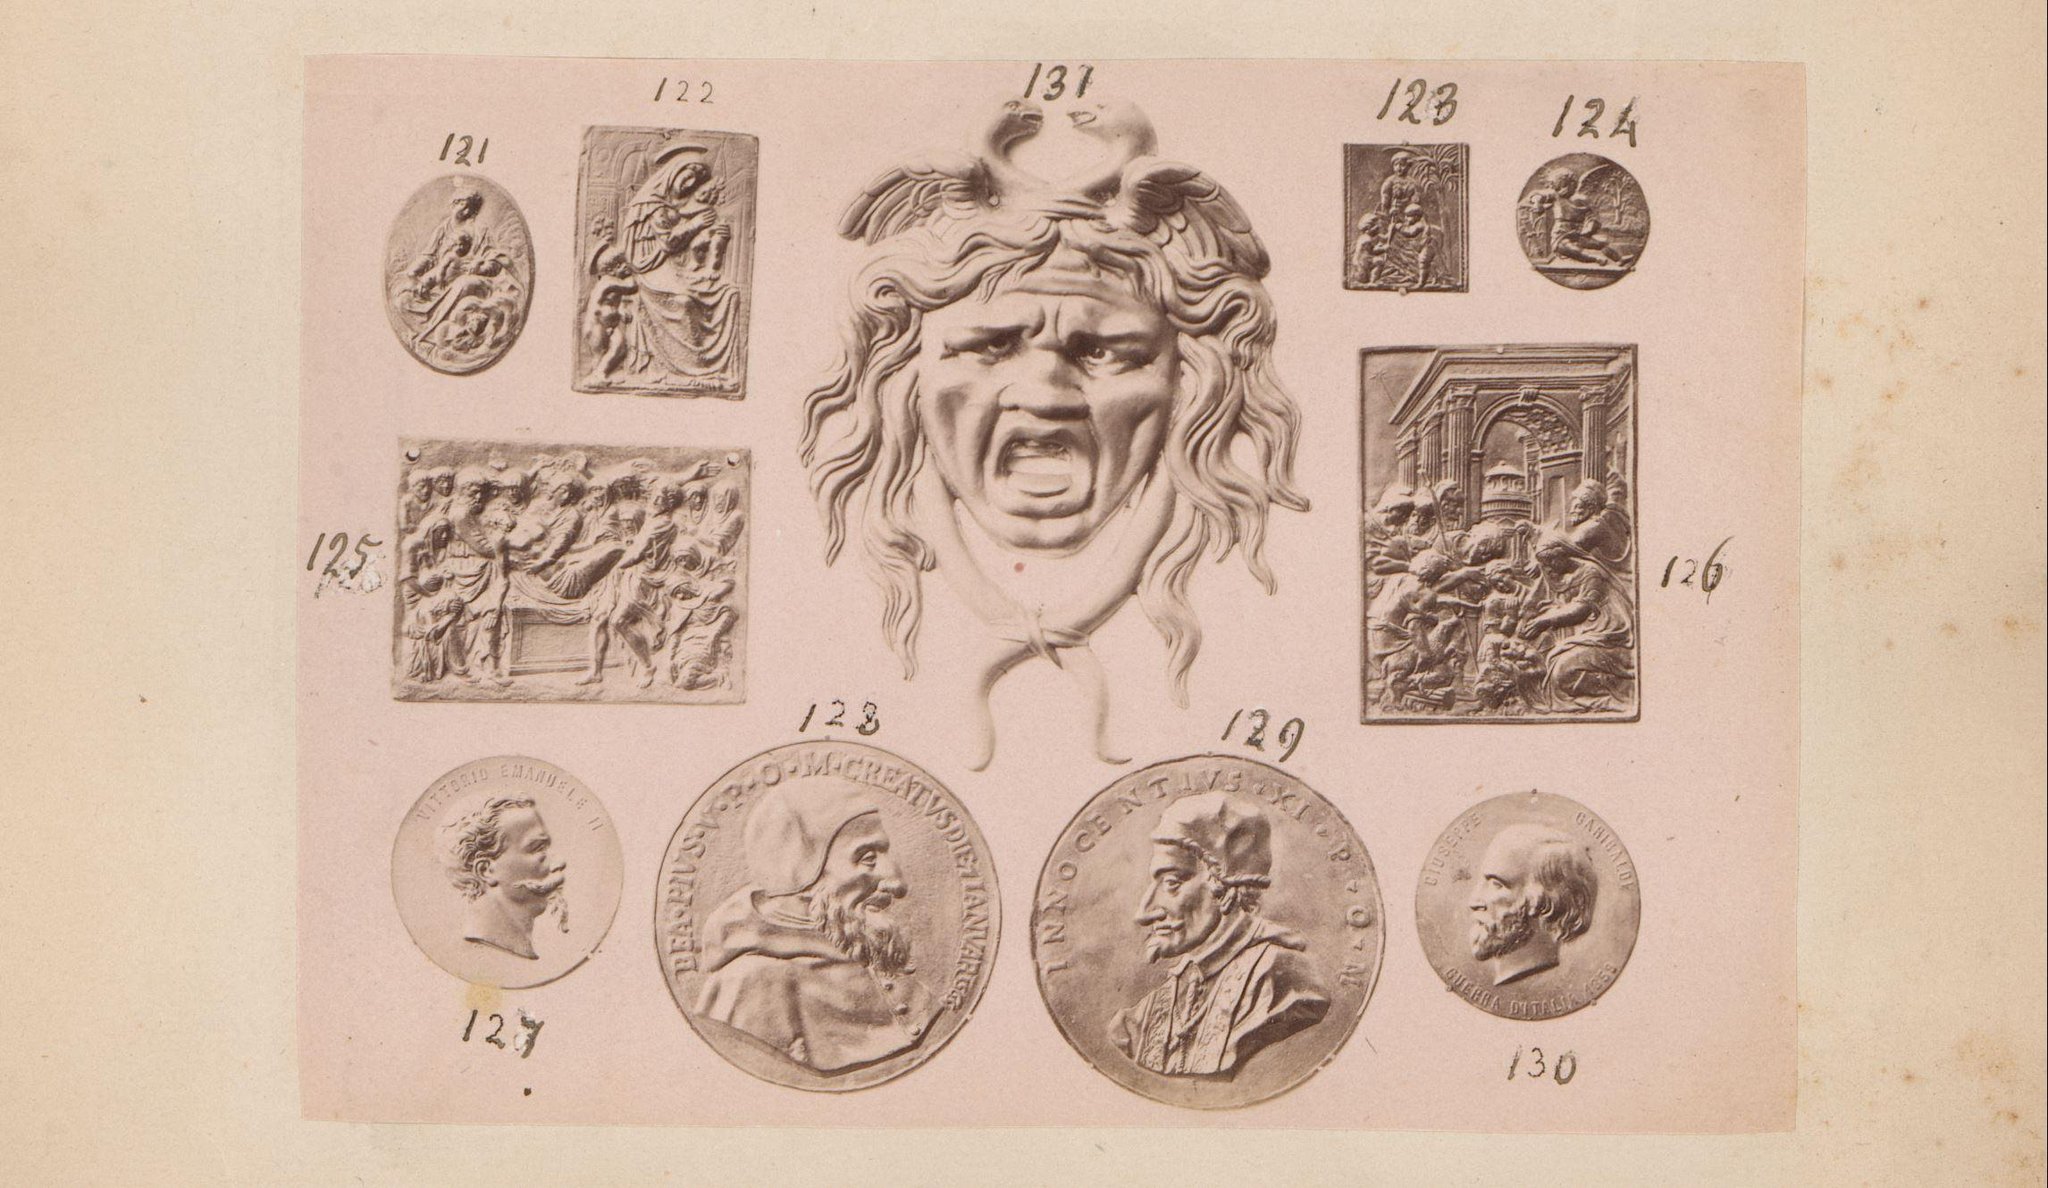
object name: photograph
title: Metalen plaquettes en munten en een Medusakop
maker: Anonymous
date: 1860-1885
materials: photographic support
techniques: albumen print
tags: ornaments ~ art, medusa (one of the gorgons), coin